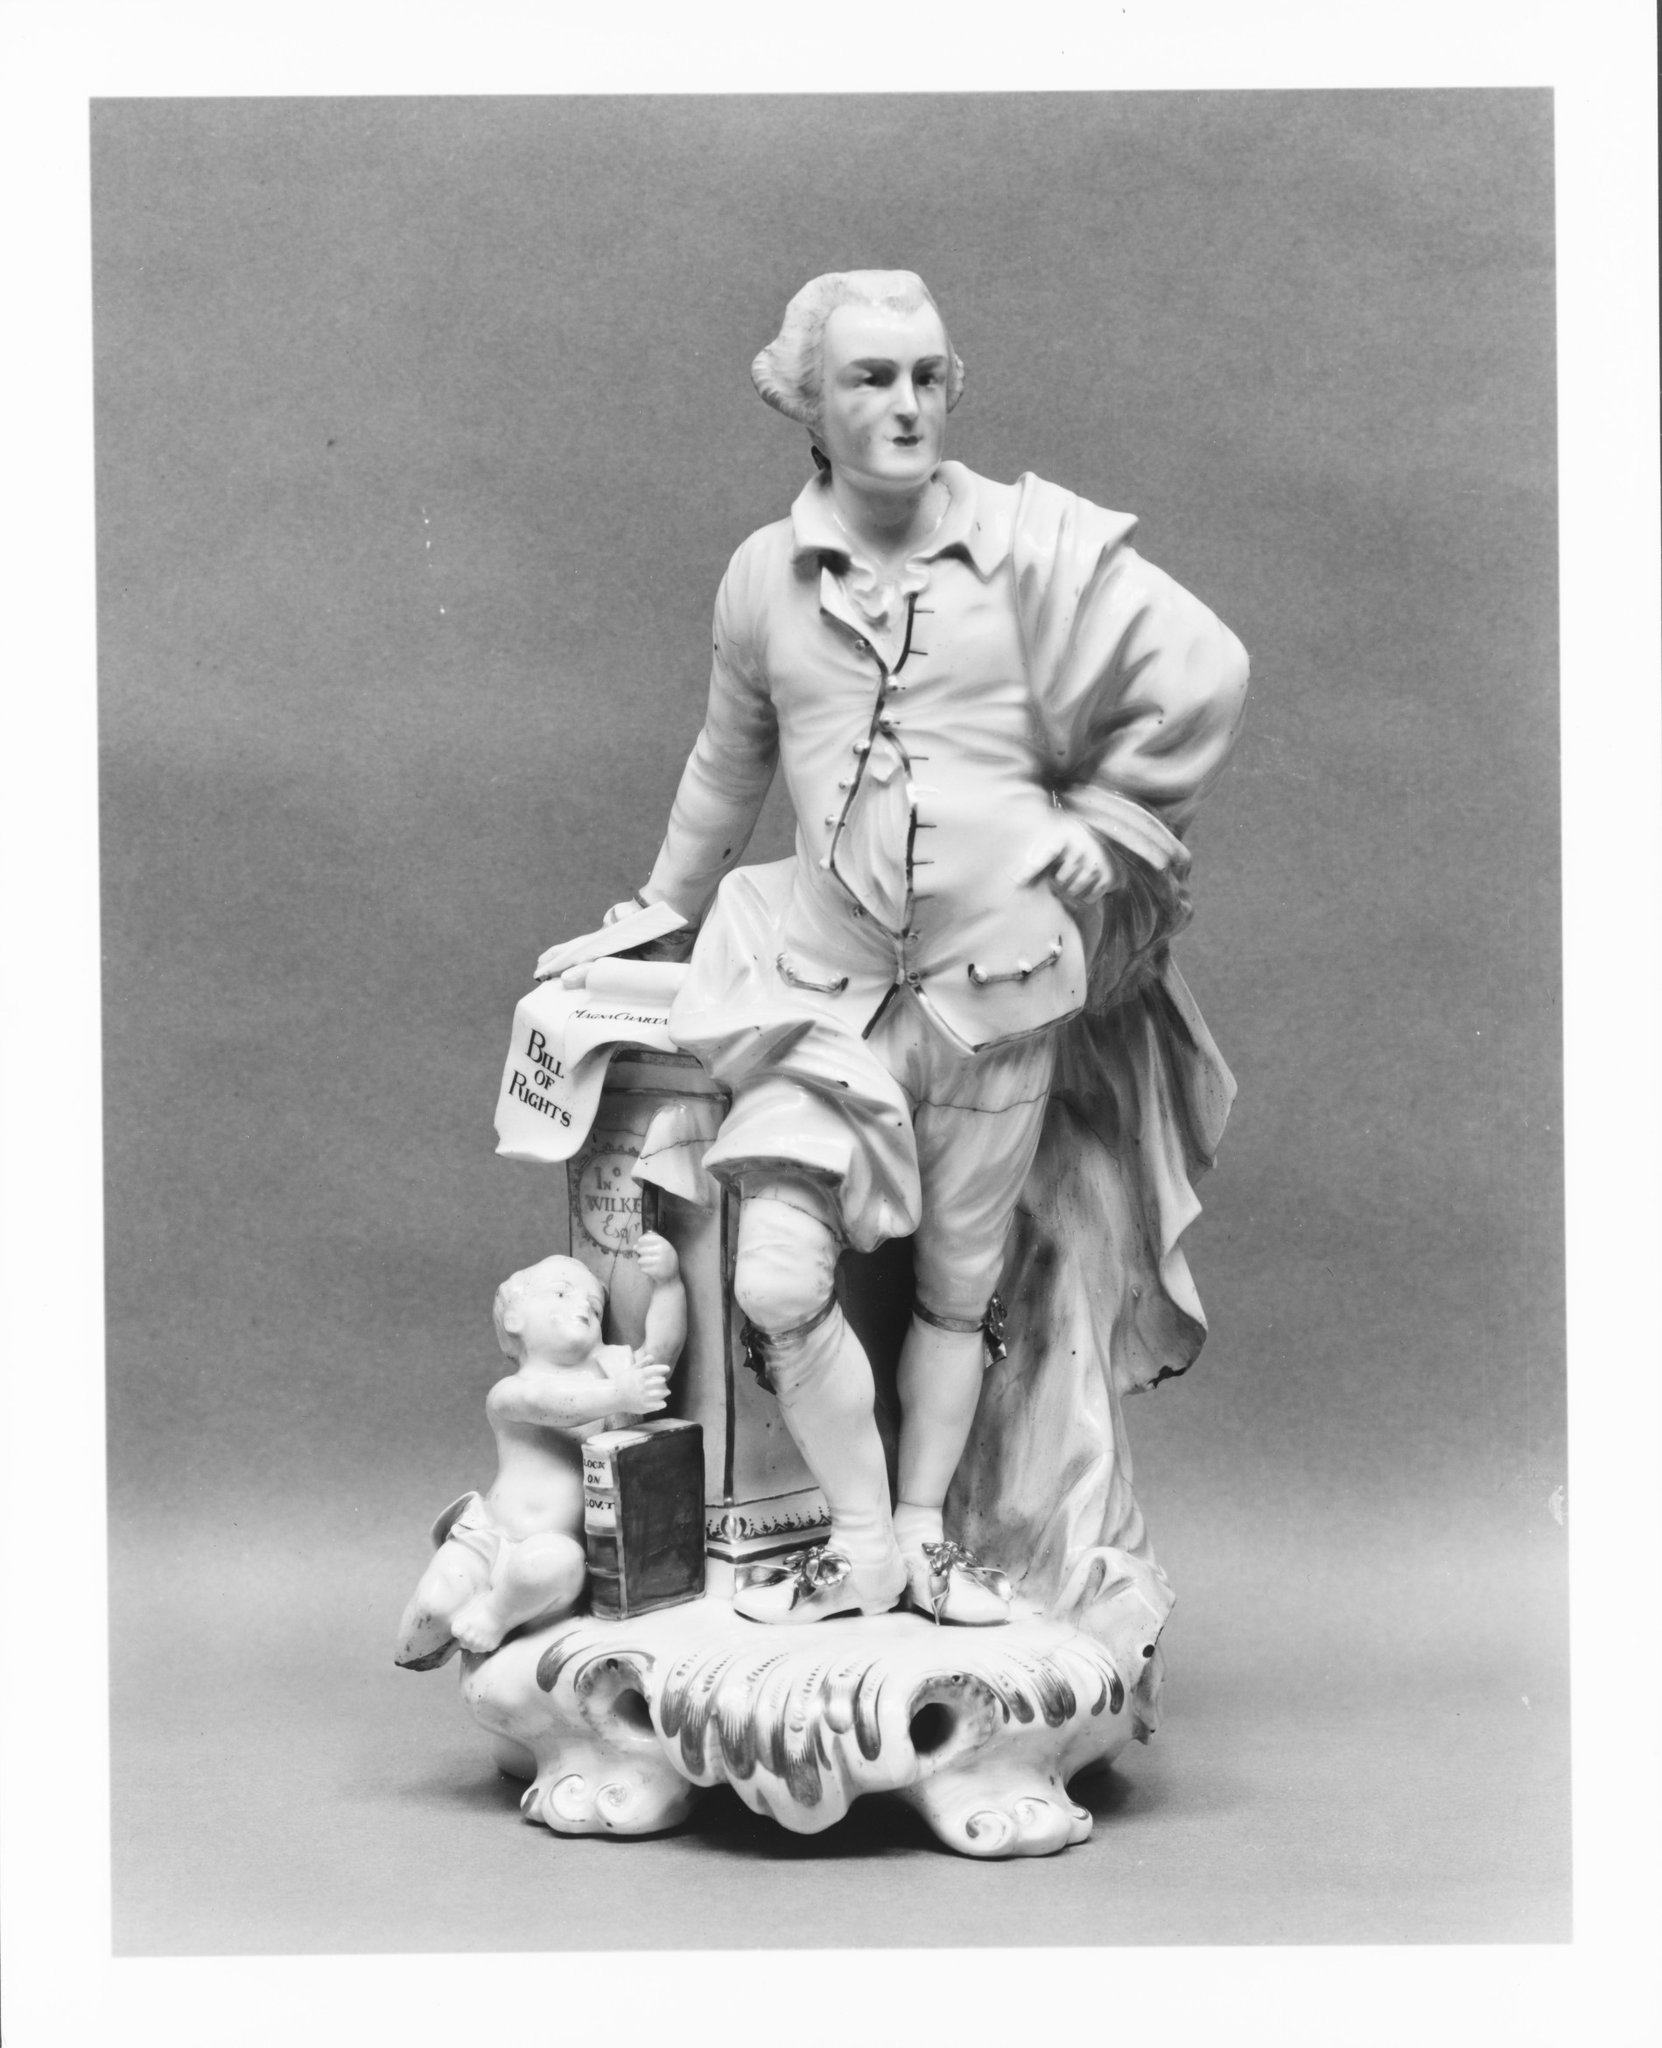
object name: figure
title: Figure of John Wilkes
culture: british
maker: chelsea factory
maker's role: maker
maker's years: 1742-1784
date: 1775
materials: porcelain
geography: england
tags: men,cupid